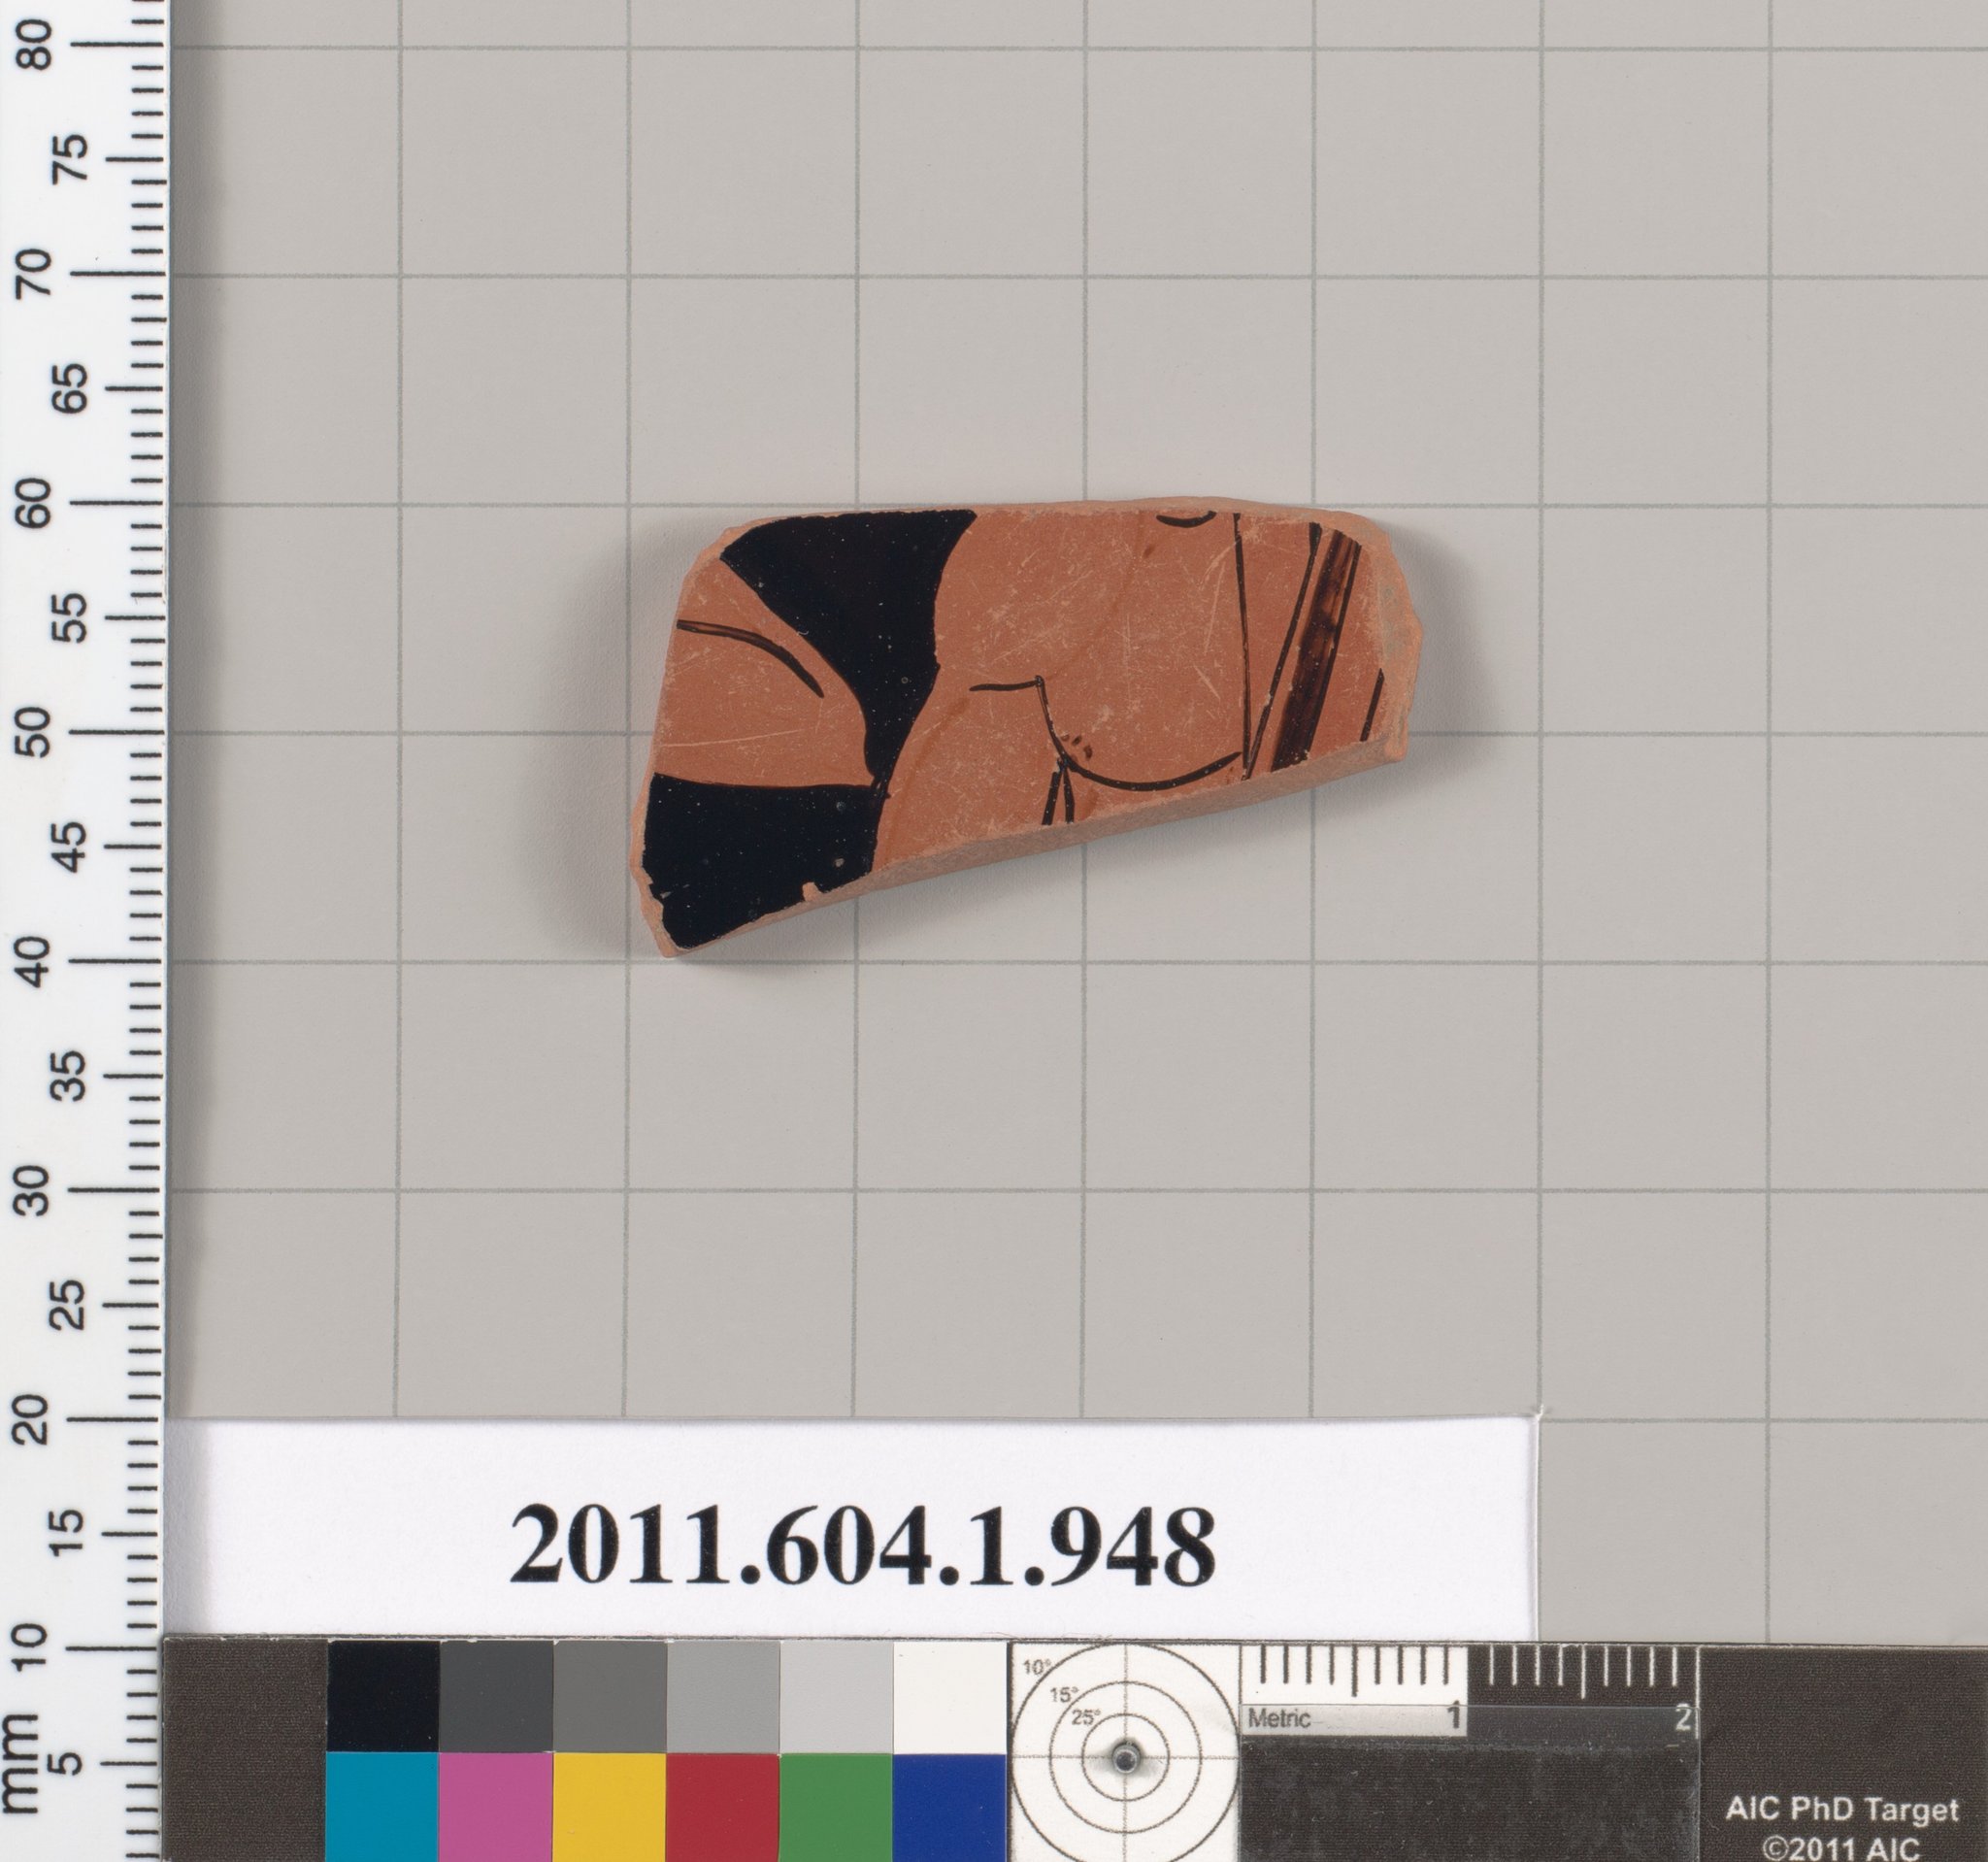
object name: kylix fragment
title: Terracotta fragment of a kylix (drinking cup)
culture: greek, attic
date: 500-476 BCE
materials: terracotta